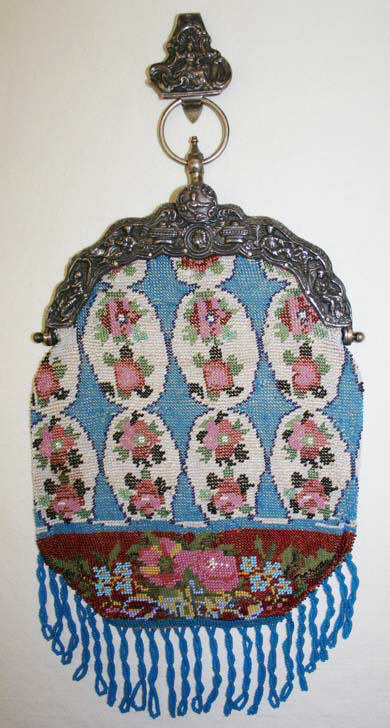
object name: bag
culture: american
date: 1870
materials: silver